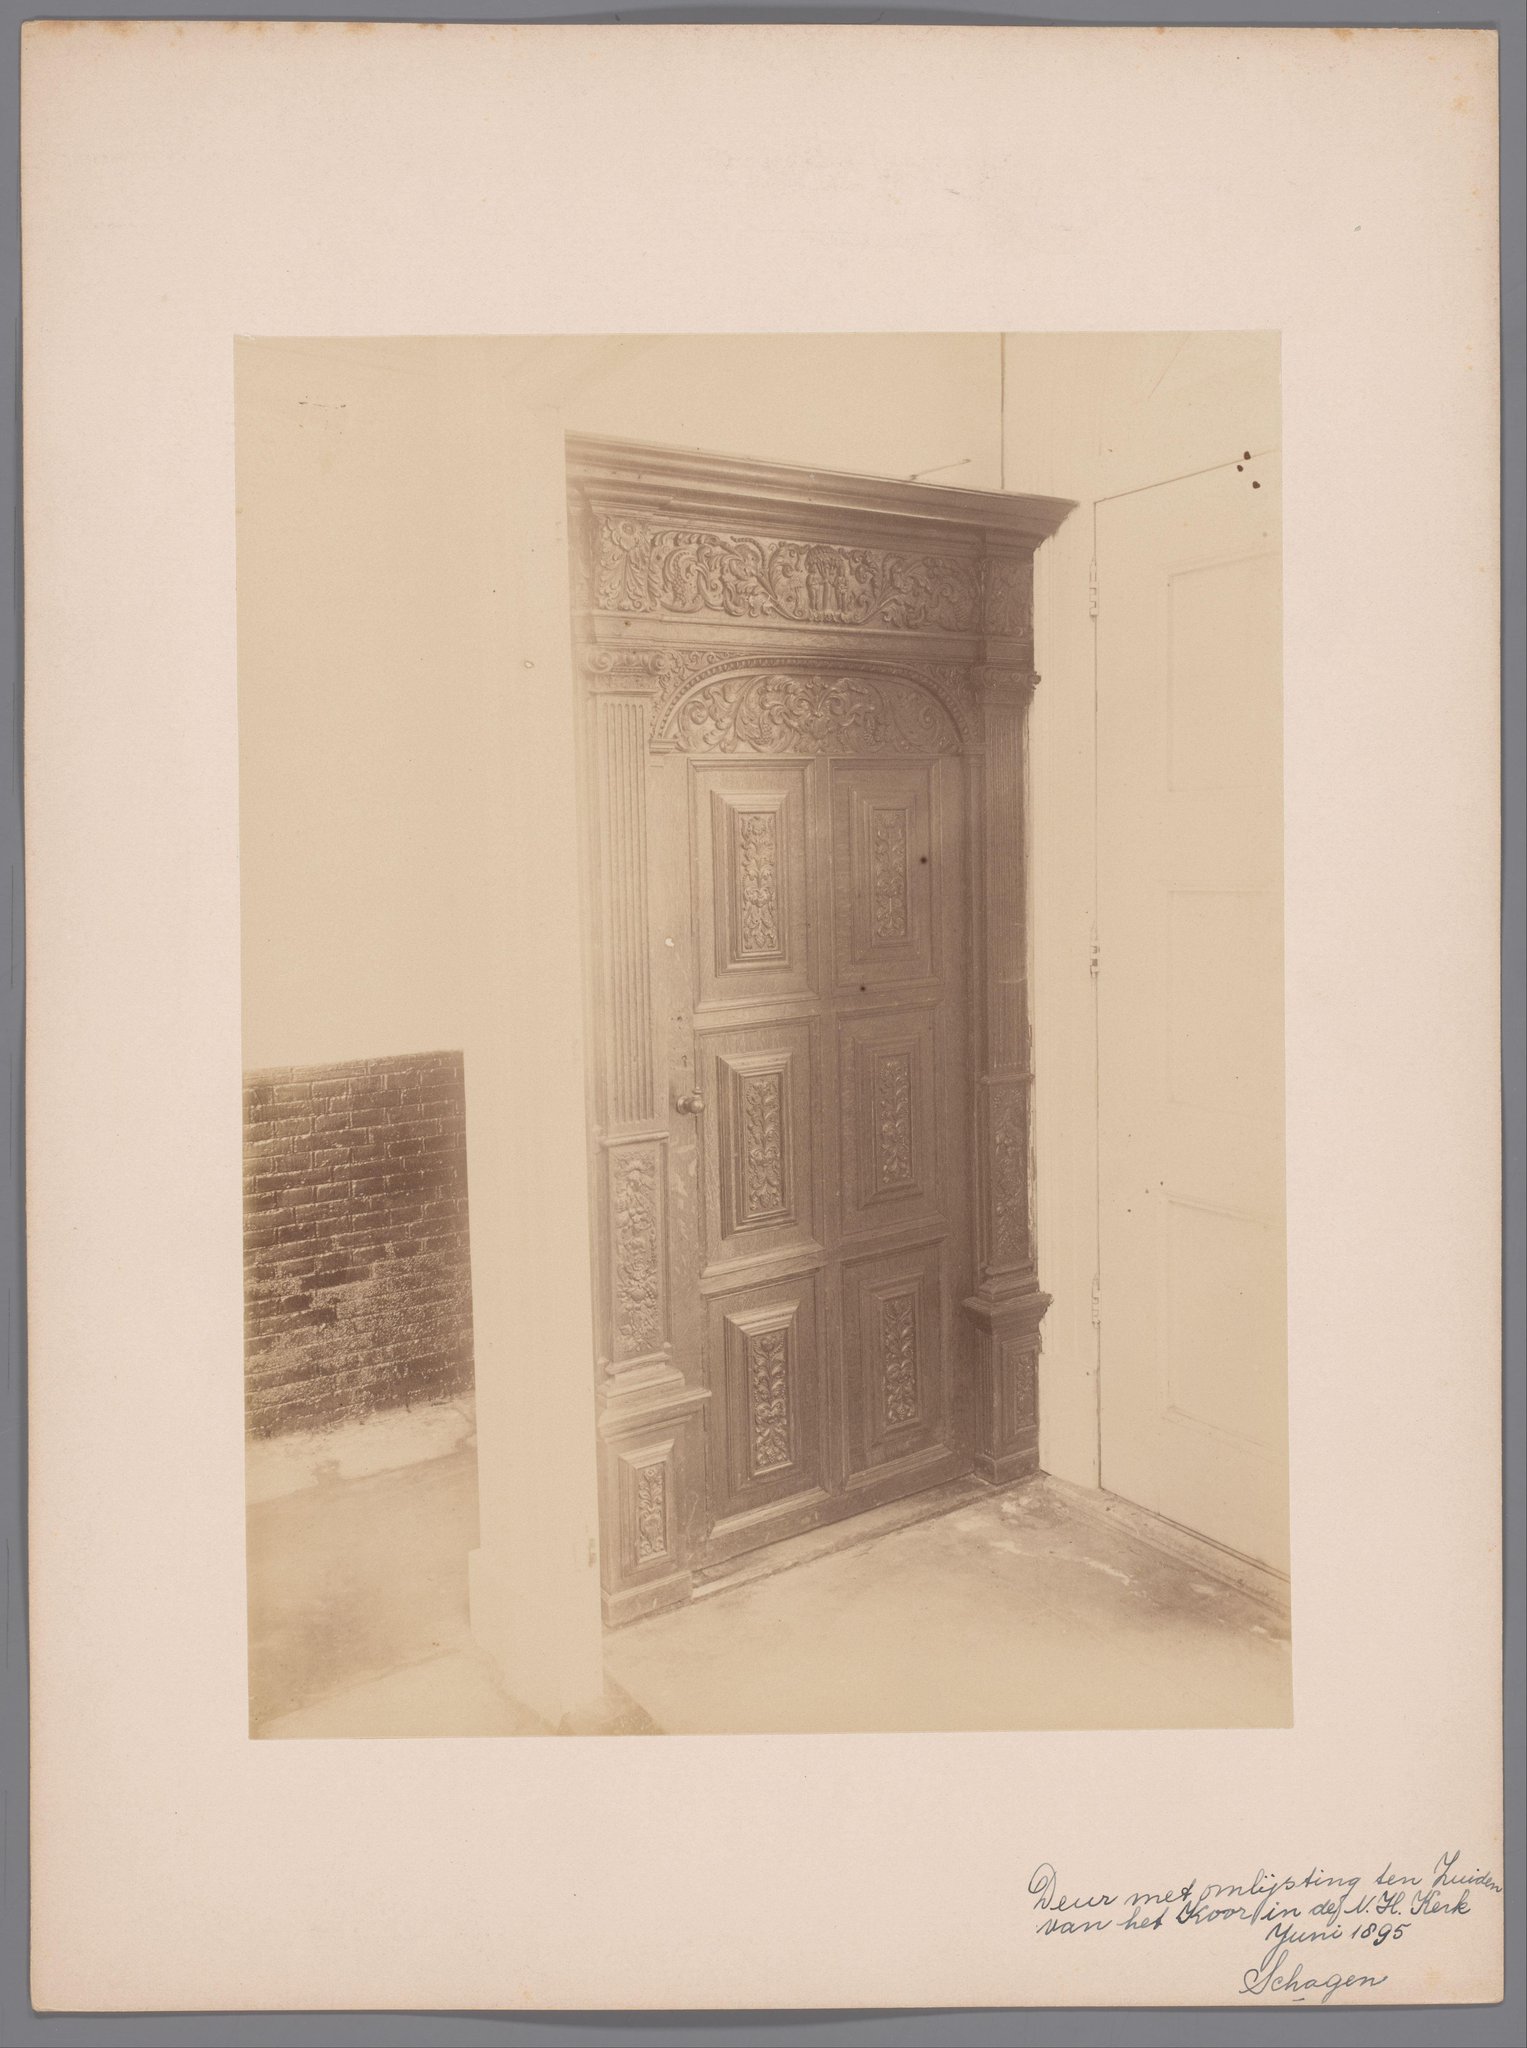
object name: photograph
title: Deur met omlijsting in de Nederlands-Hervormde Kerk te Schagen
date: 1895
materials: cardboard, photographic support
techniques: albumen print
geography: schagen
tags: door, parts of church interior, schagen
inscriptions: annotation: ‘Schagen (N.H.)/ Deur met omlijsting ten zuiden van het koor in de NH Kerk/ Juni 1895’, annotation: ‘Deur met omlijsting ten Zuiden van het Koor in de N.H. Kerk/ Juni 1895/ Schagen’